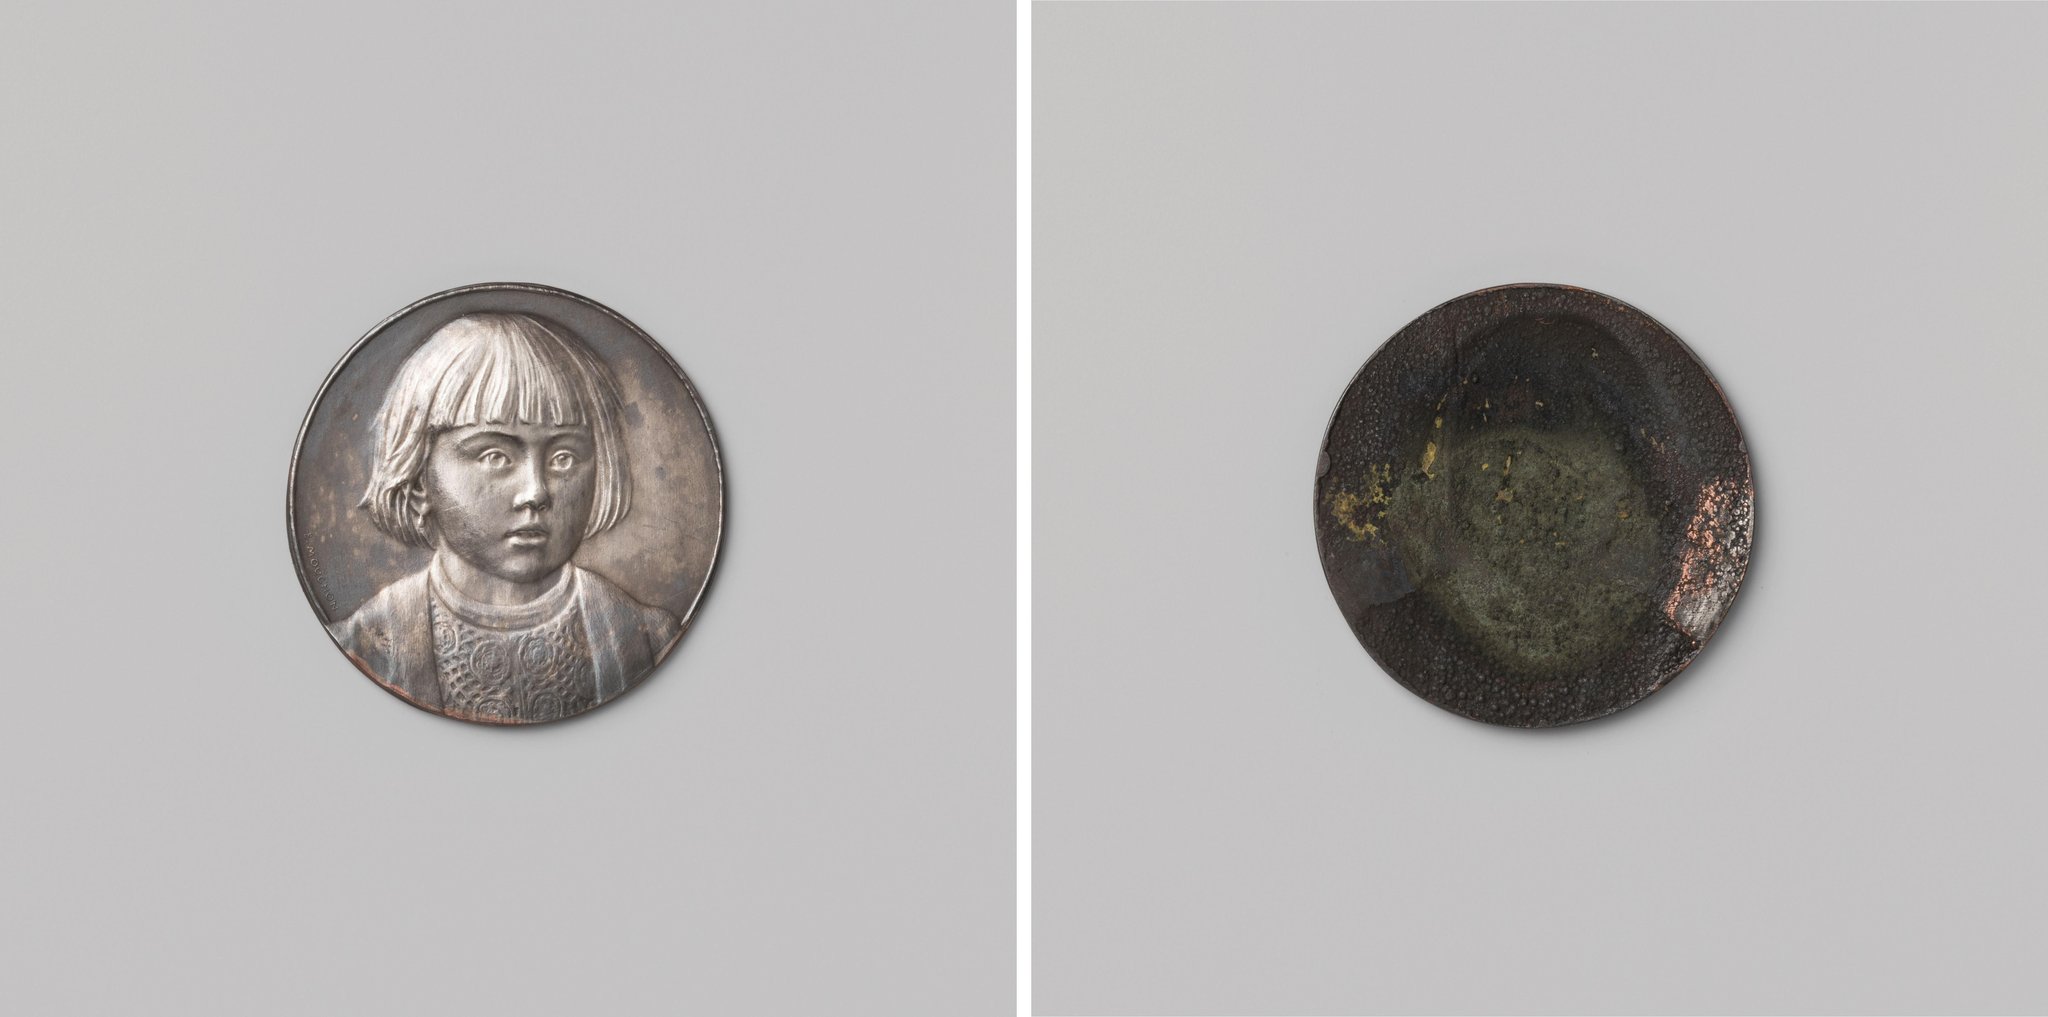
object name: medal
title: kinderportret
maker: louis eugène mouchon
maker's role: medailleur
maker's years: 1843-1914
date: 1895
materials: silver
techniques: casting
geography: paris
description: Eenzijdige zilveren penning. Voorzijde: borststuk jong meisje. Keerzijde: blanco.